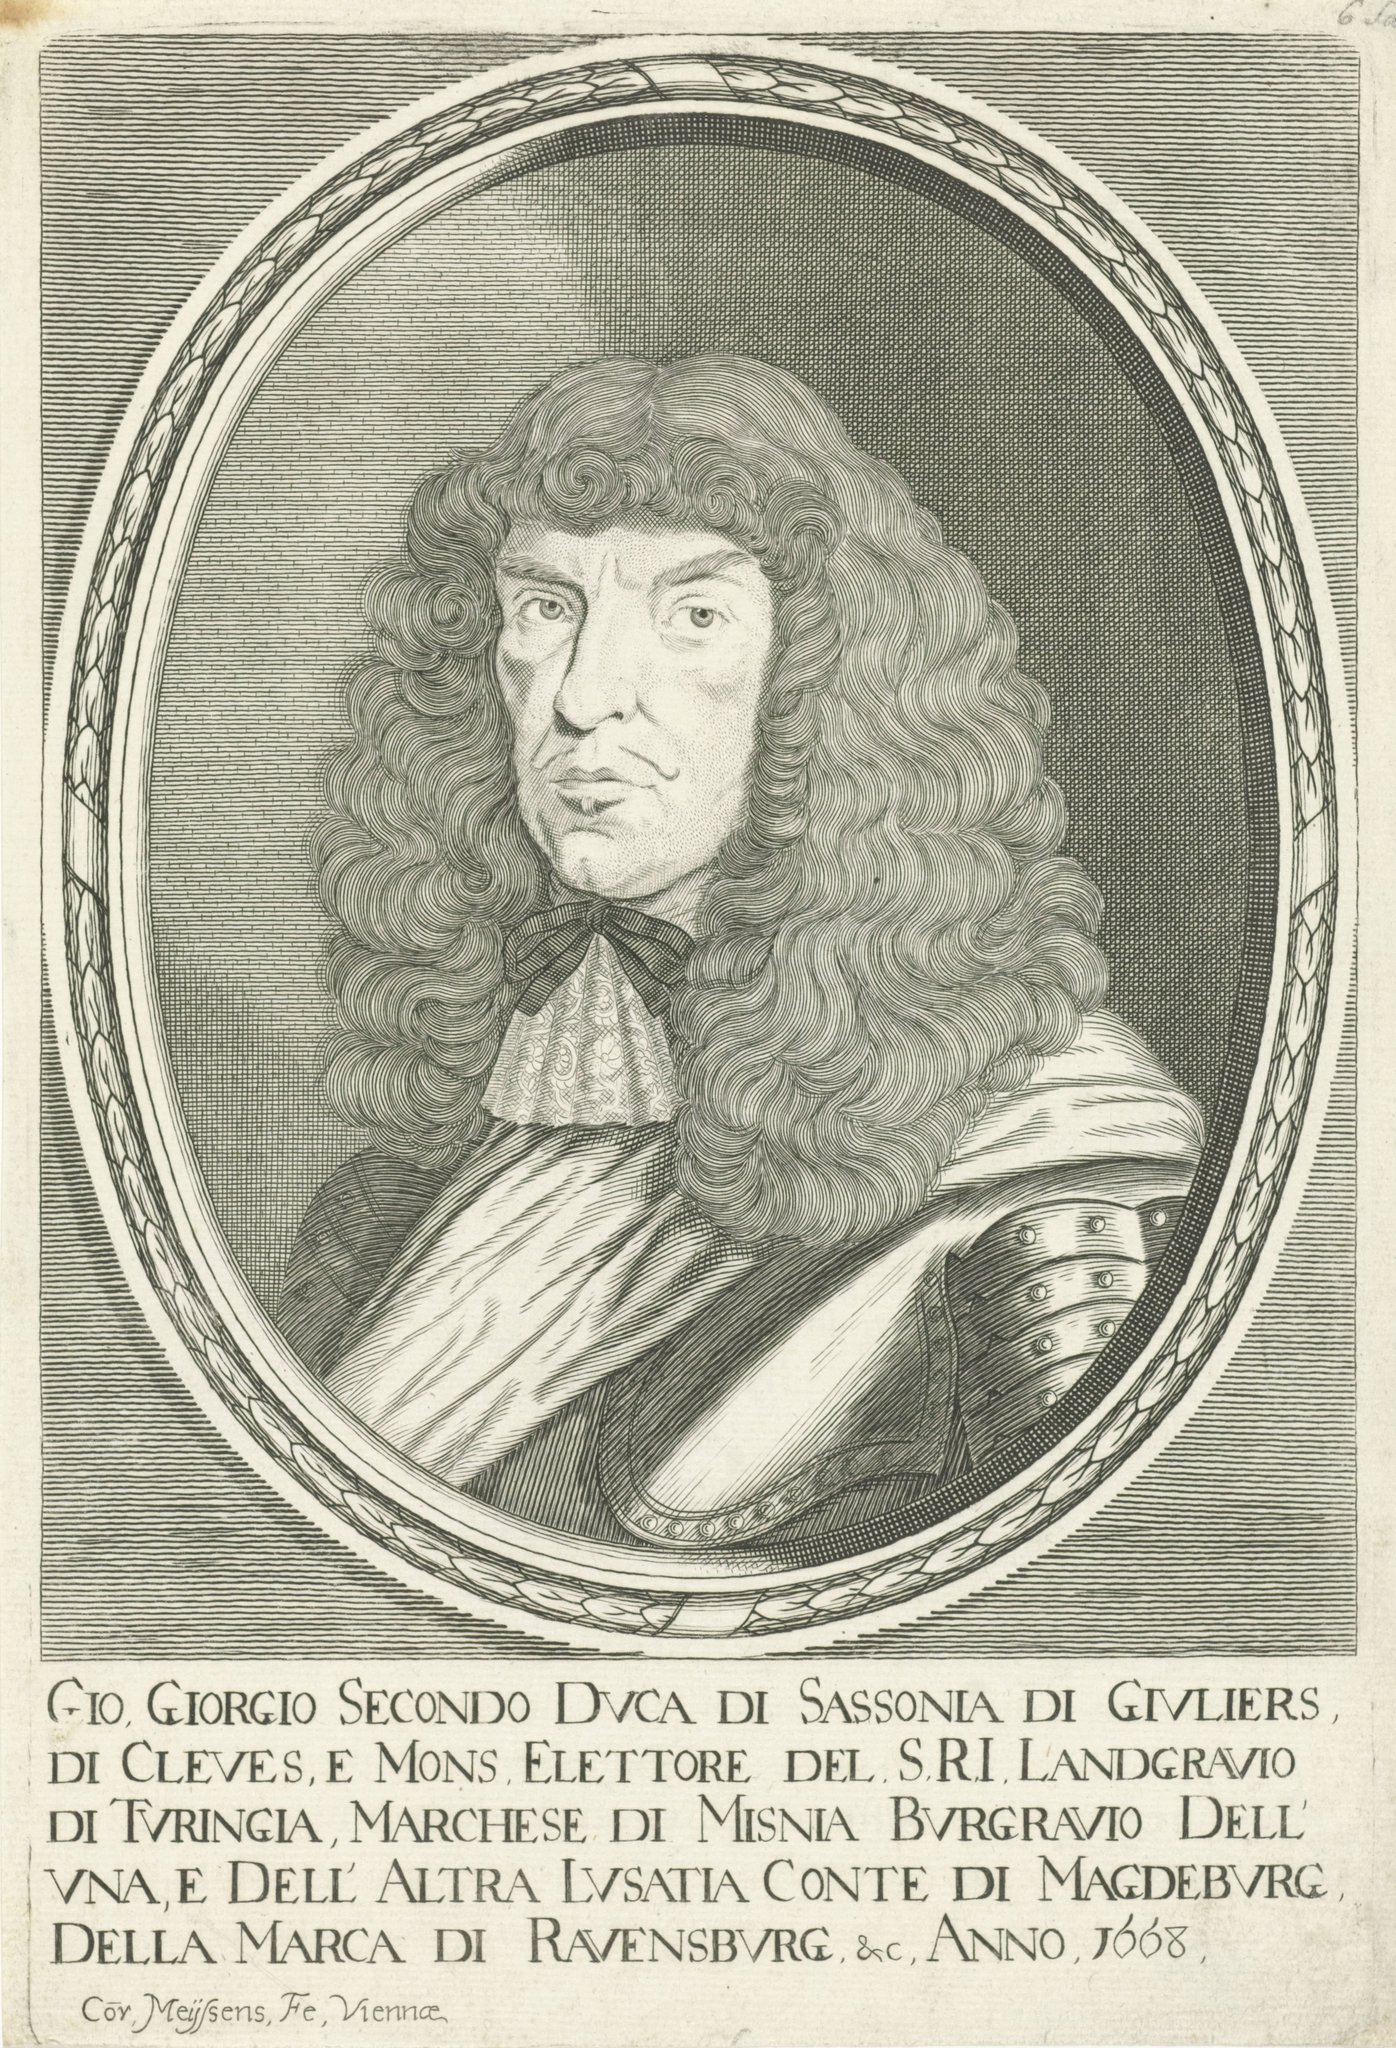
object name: book illustration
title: Portret van keurvorst Johan Georg II van Saksen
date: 1670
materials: paper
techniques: engraving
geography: vienna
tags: freiberg, keurvorst, keurvorst van saksen johan georg ii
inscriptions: collector's mark: Lugt 2228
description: Prent gebruikt in: Gualdo Priorato, Galeazzo. Historia di Leopoldo Cesare, (...). 3 dln. Wenen, Giovanni Battista Hacque, 1670-1674, dl. 1.